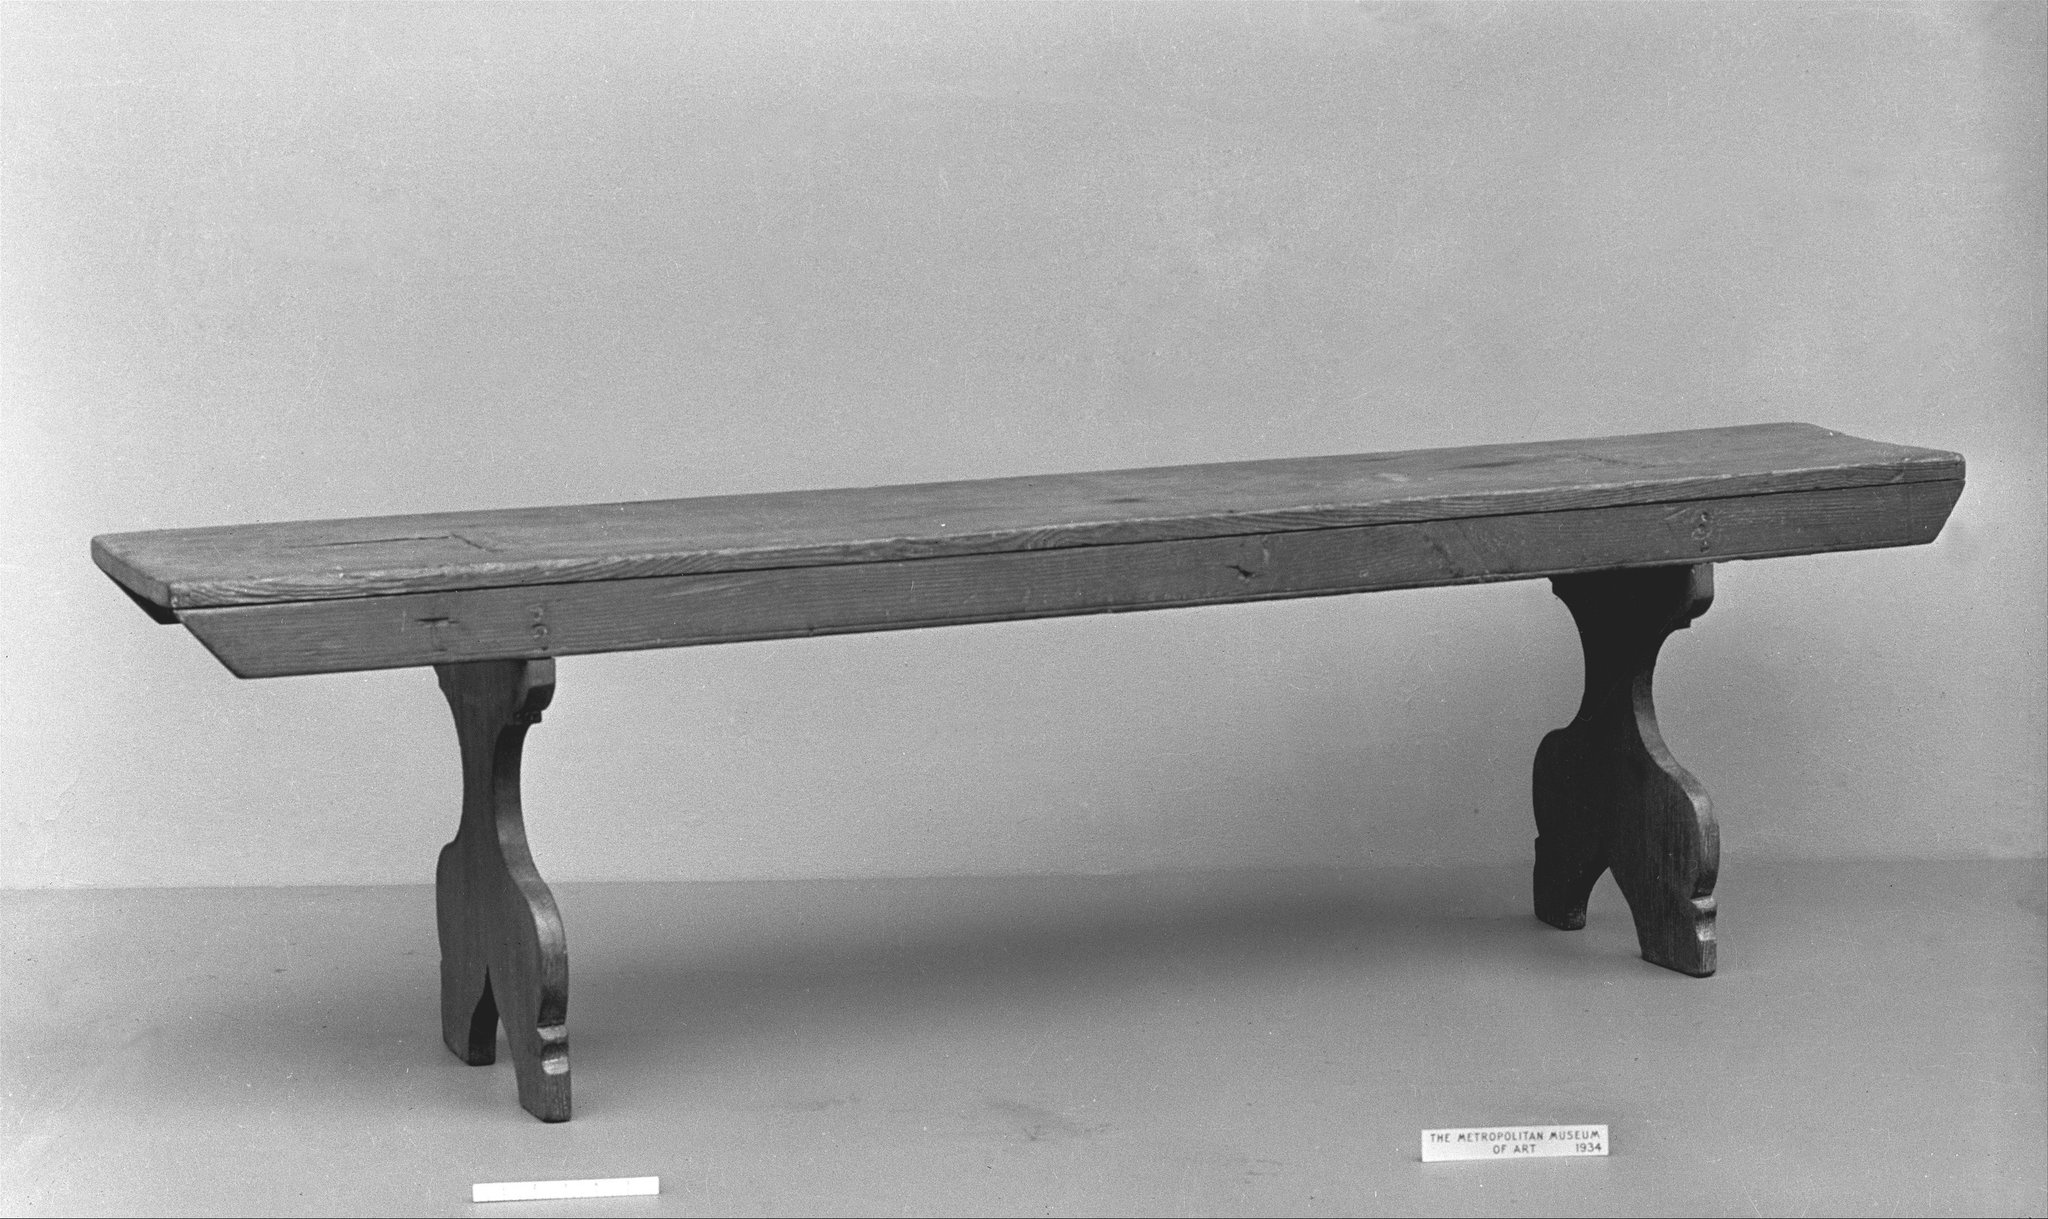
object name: bench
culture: american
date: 1740-1780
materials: wood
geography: united states